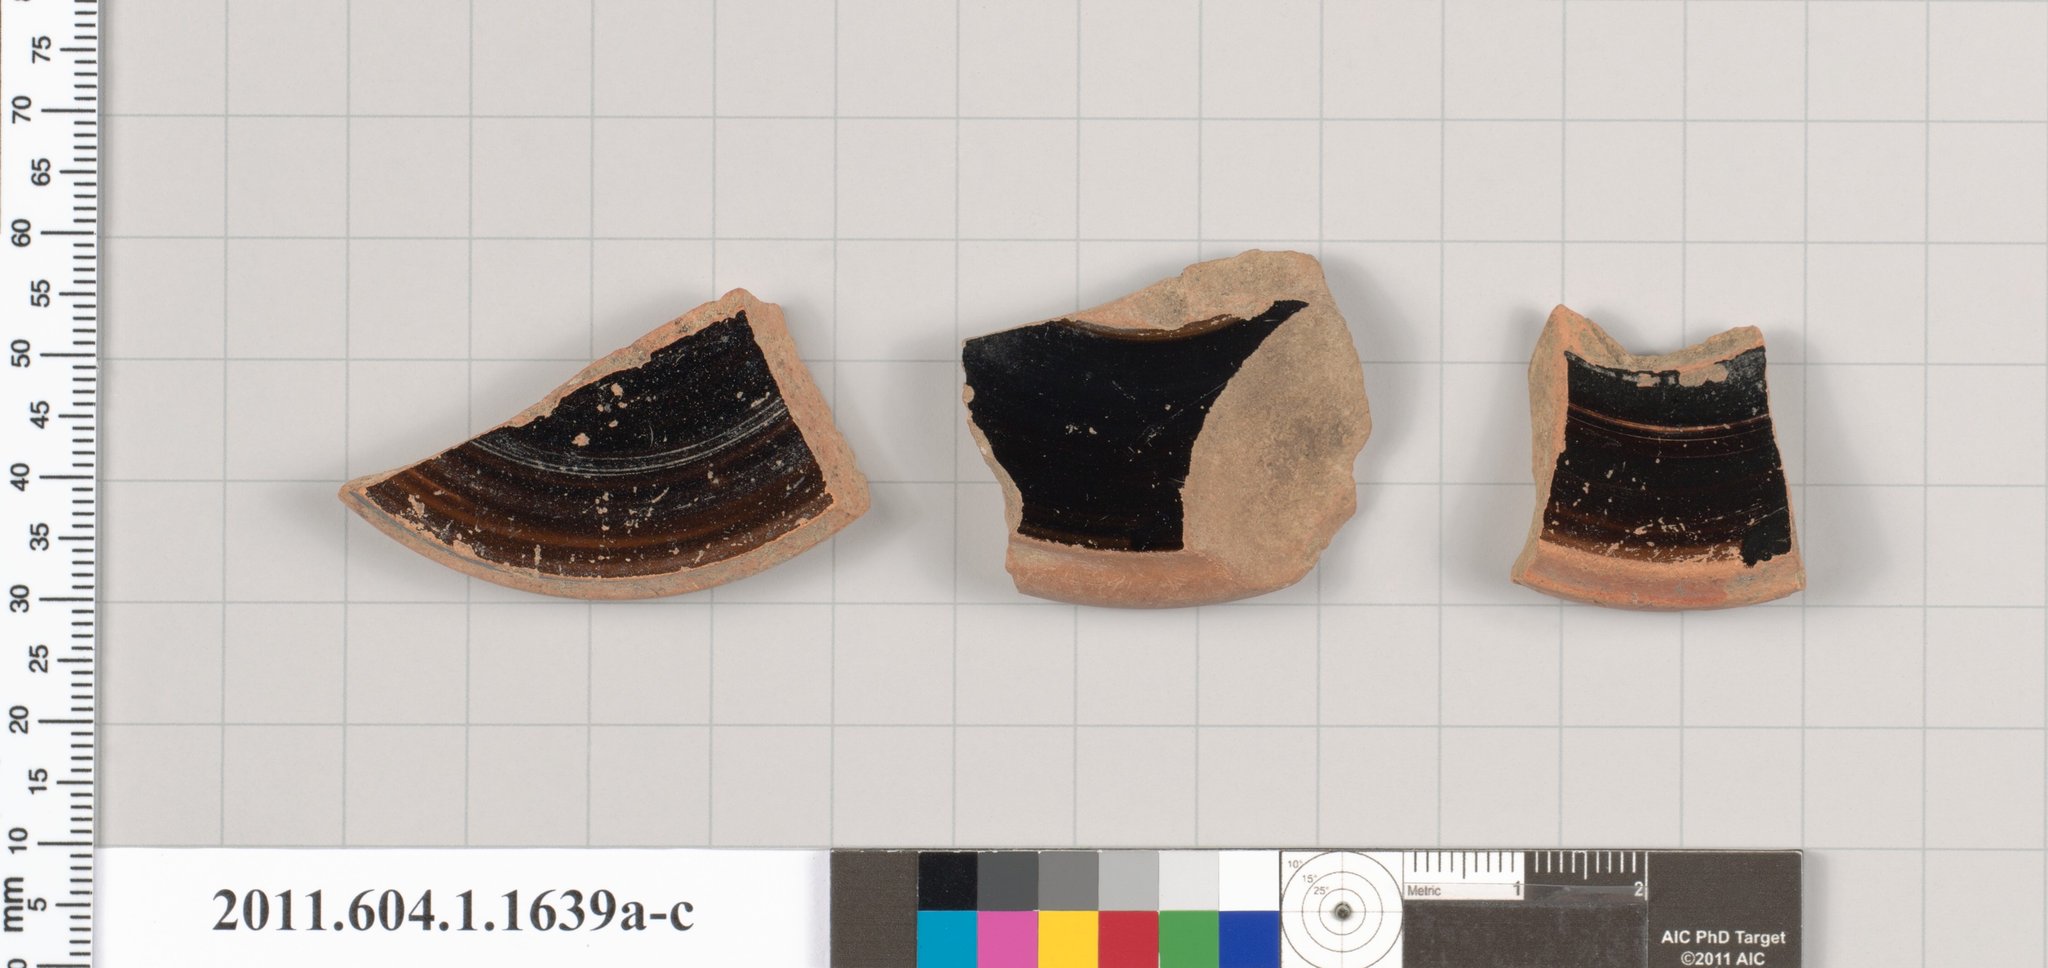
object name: kylix fragment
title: Terracotta fragments of kylikes (drinking cups)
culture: greek, attic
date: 500-401 BCE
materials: terracotta